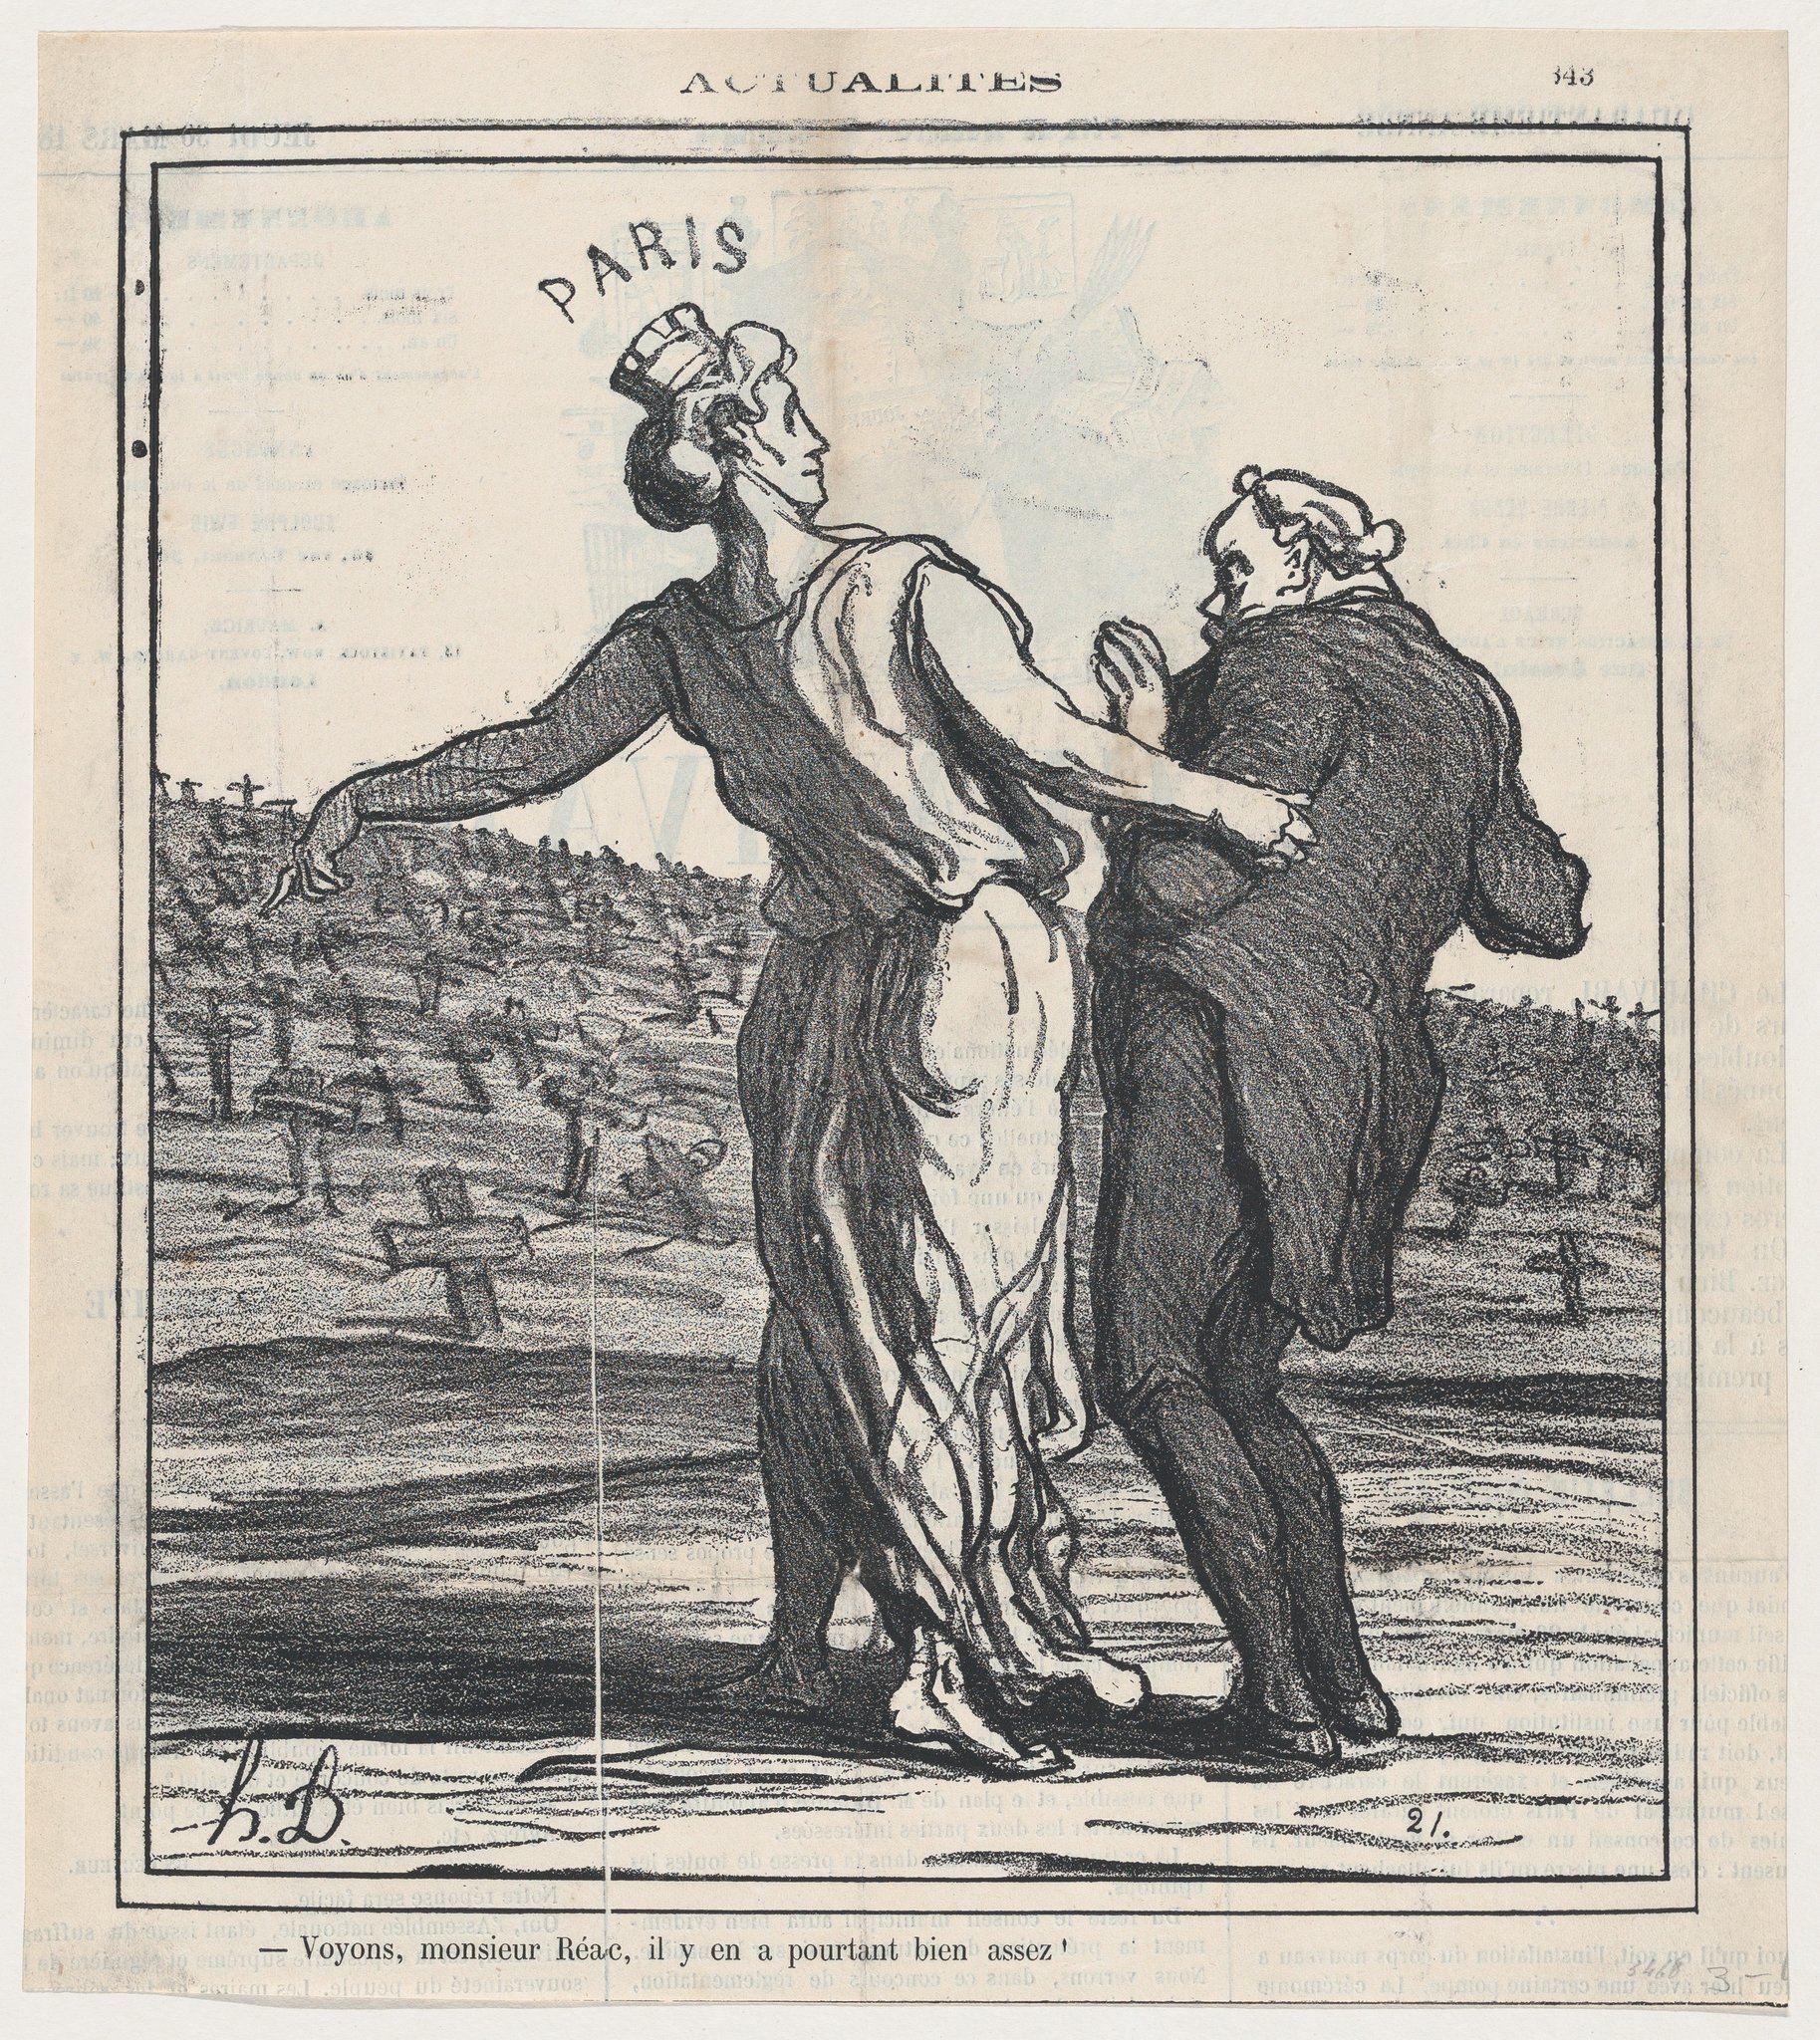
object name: print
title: See, Mr. Réac, it is quite enought!, from 'News of the day,' published in "Le Charivari"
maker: honoré daumier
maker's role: artist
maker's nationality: french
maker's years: 1808-1879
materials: paper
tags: men,women